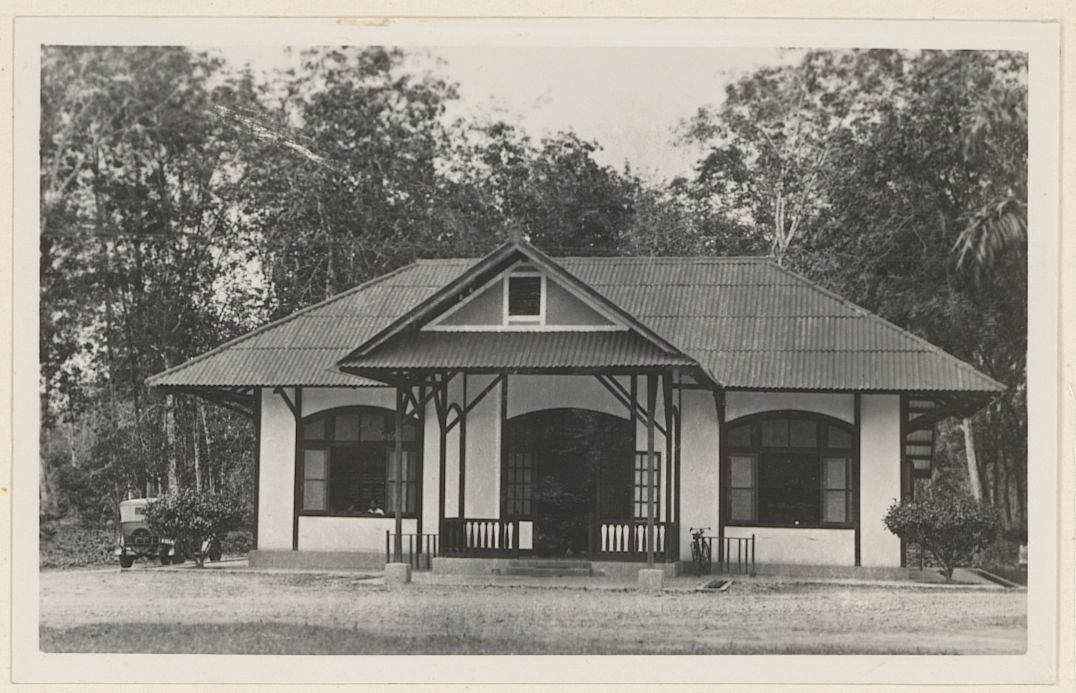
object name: photograph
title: Hoofd Administratie : Bureau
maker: Anonymous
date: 1933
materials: photographic support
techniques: gelatin silver print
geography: sumatra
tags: plantation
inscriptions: inscription: ‘Hoofd Administratie : Bureau (Reçu 2-10-33)’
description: Het bureau van de hoofadministratie van de Sucama bij de plantage Pernantian. Met etiket met onderschrift onder de foto. Onderdeel van het fotoalbum over de plantages Brussel en Pernantian van de Sumatra Caoutchouc Maatschappij op de Oostkust van Sumatra in de jaren 1910-1935.